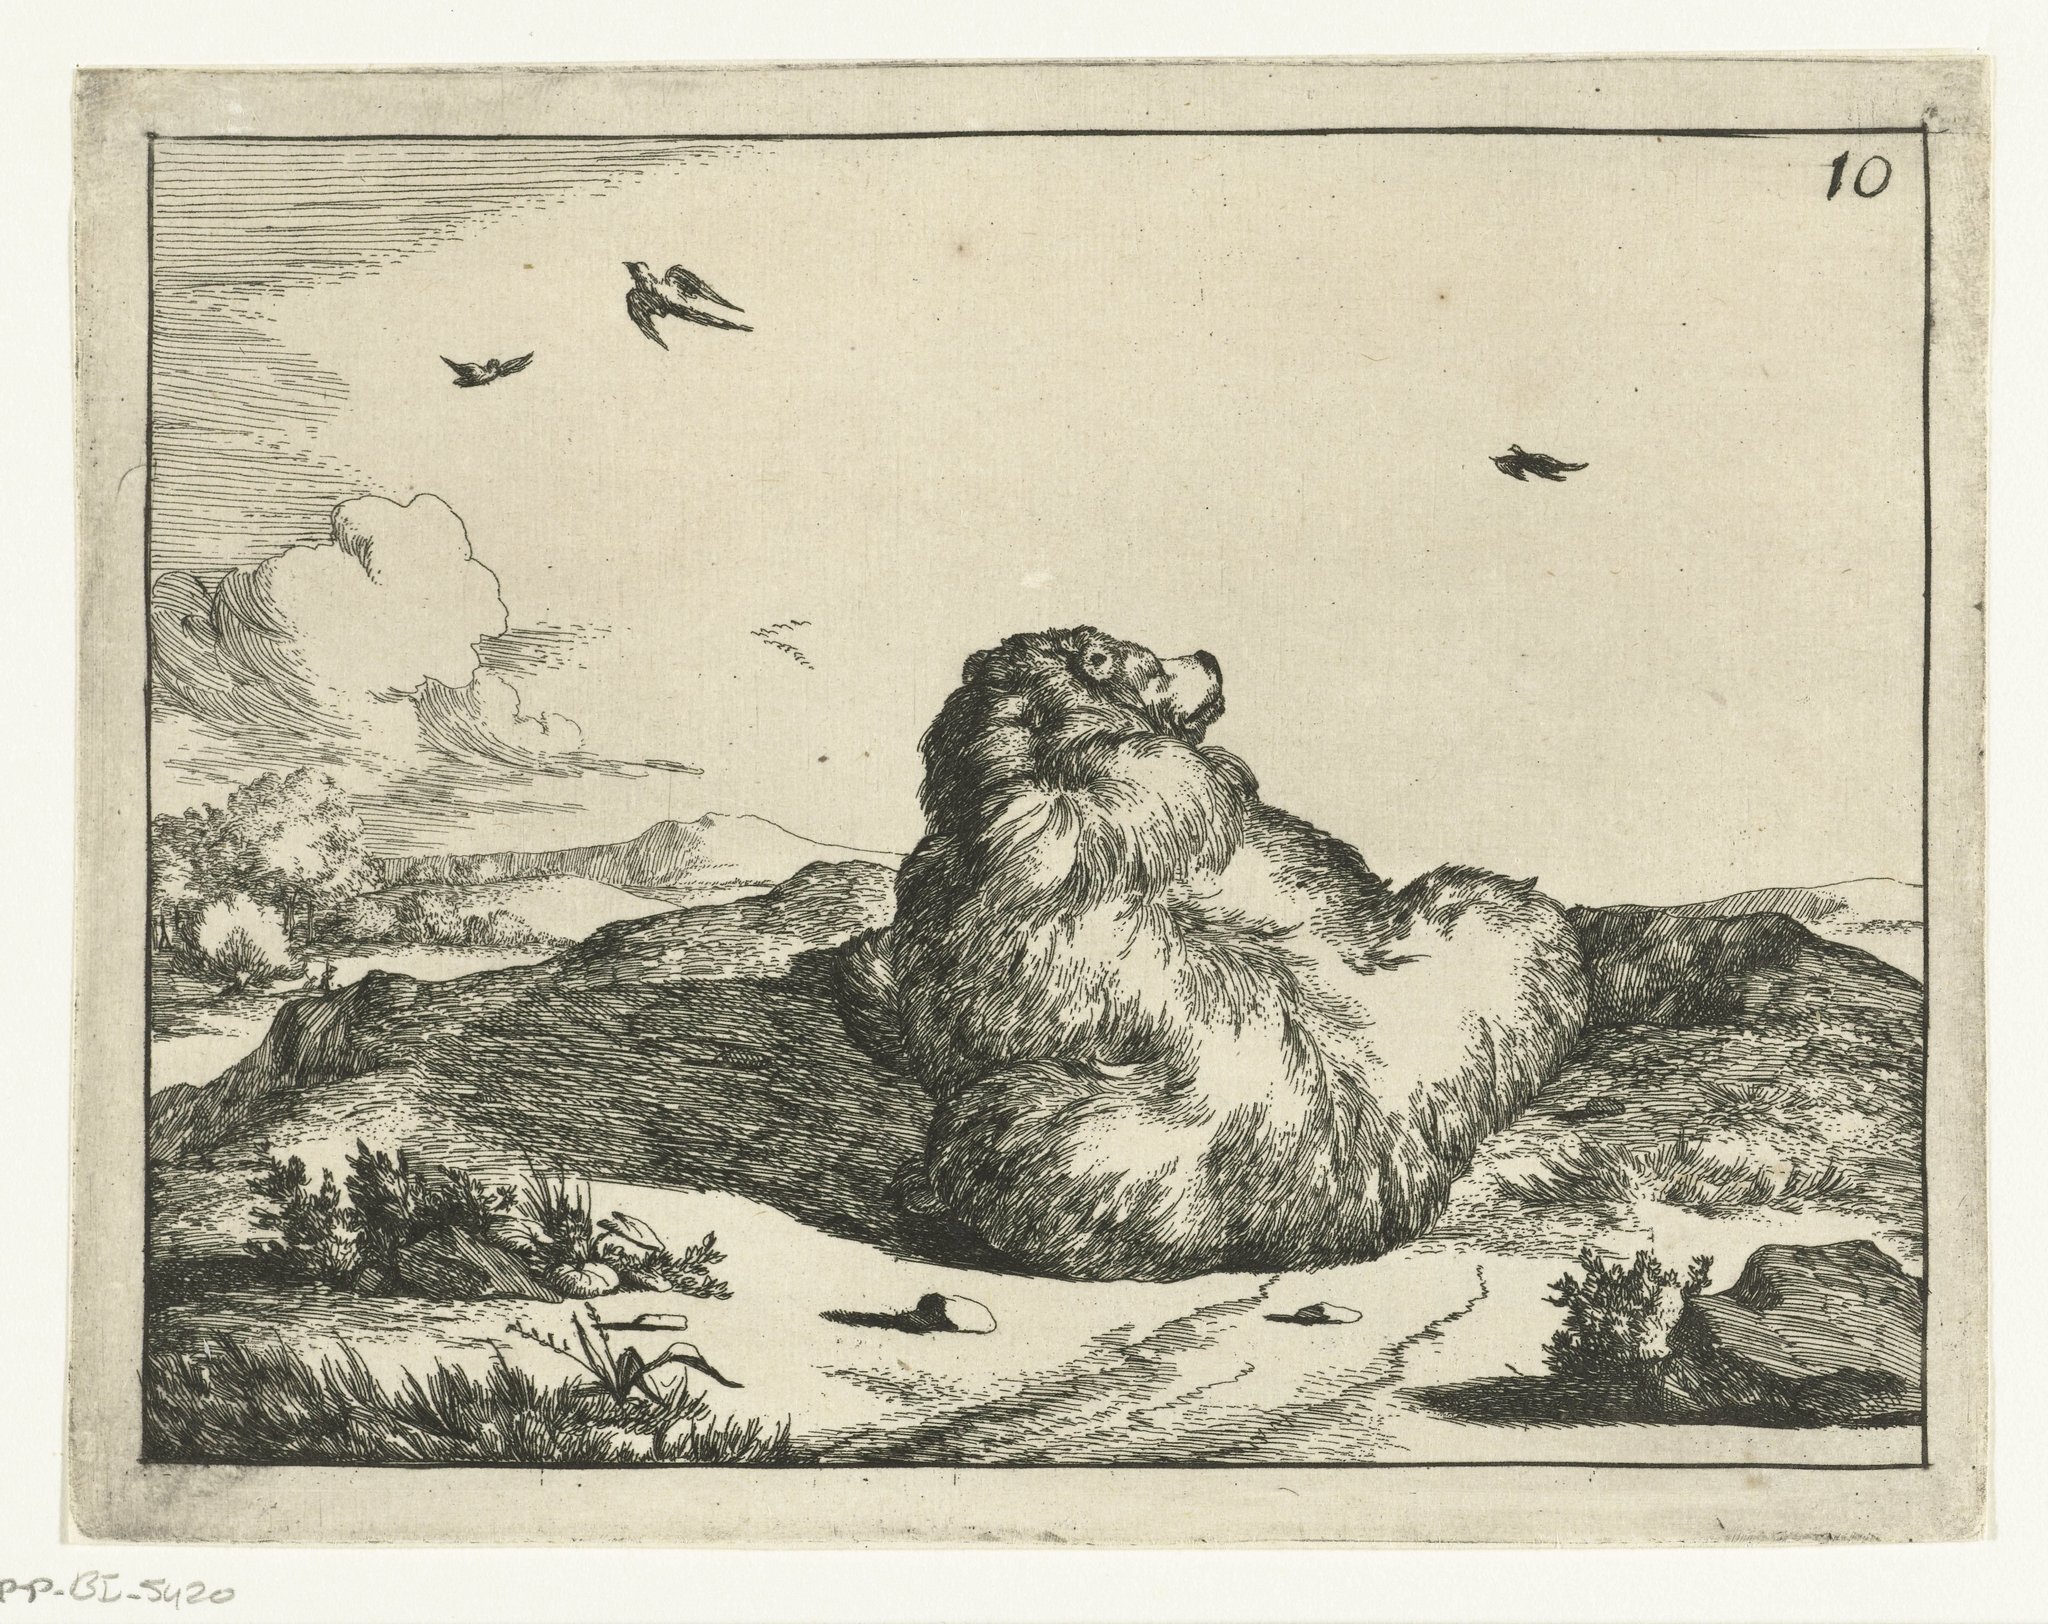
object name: print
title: Beren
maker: marcus de bye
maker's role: print maker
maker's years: 1639-1688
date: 1664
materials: paper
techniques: etching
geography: the hague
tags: beasts of prey, predatory animals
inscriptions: collector's mark: Lugt 240